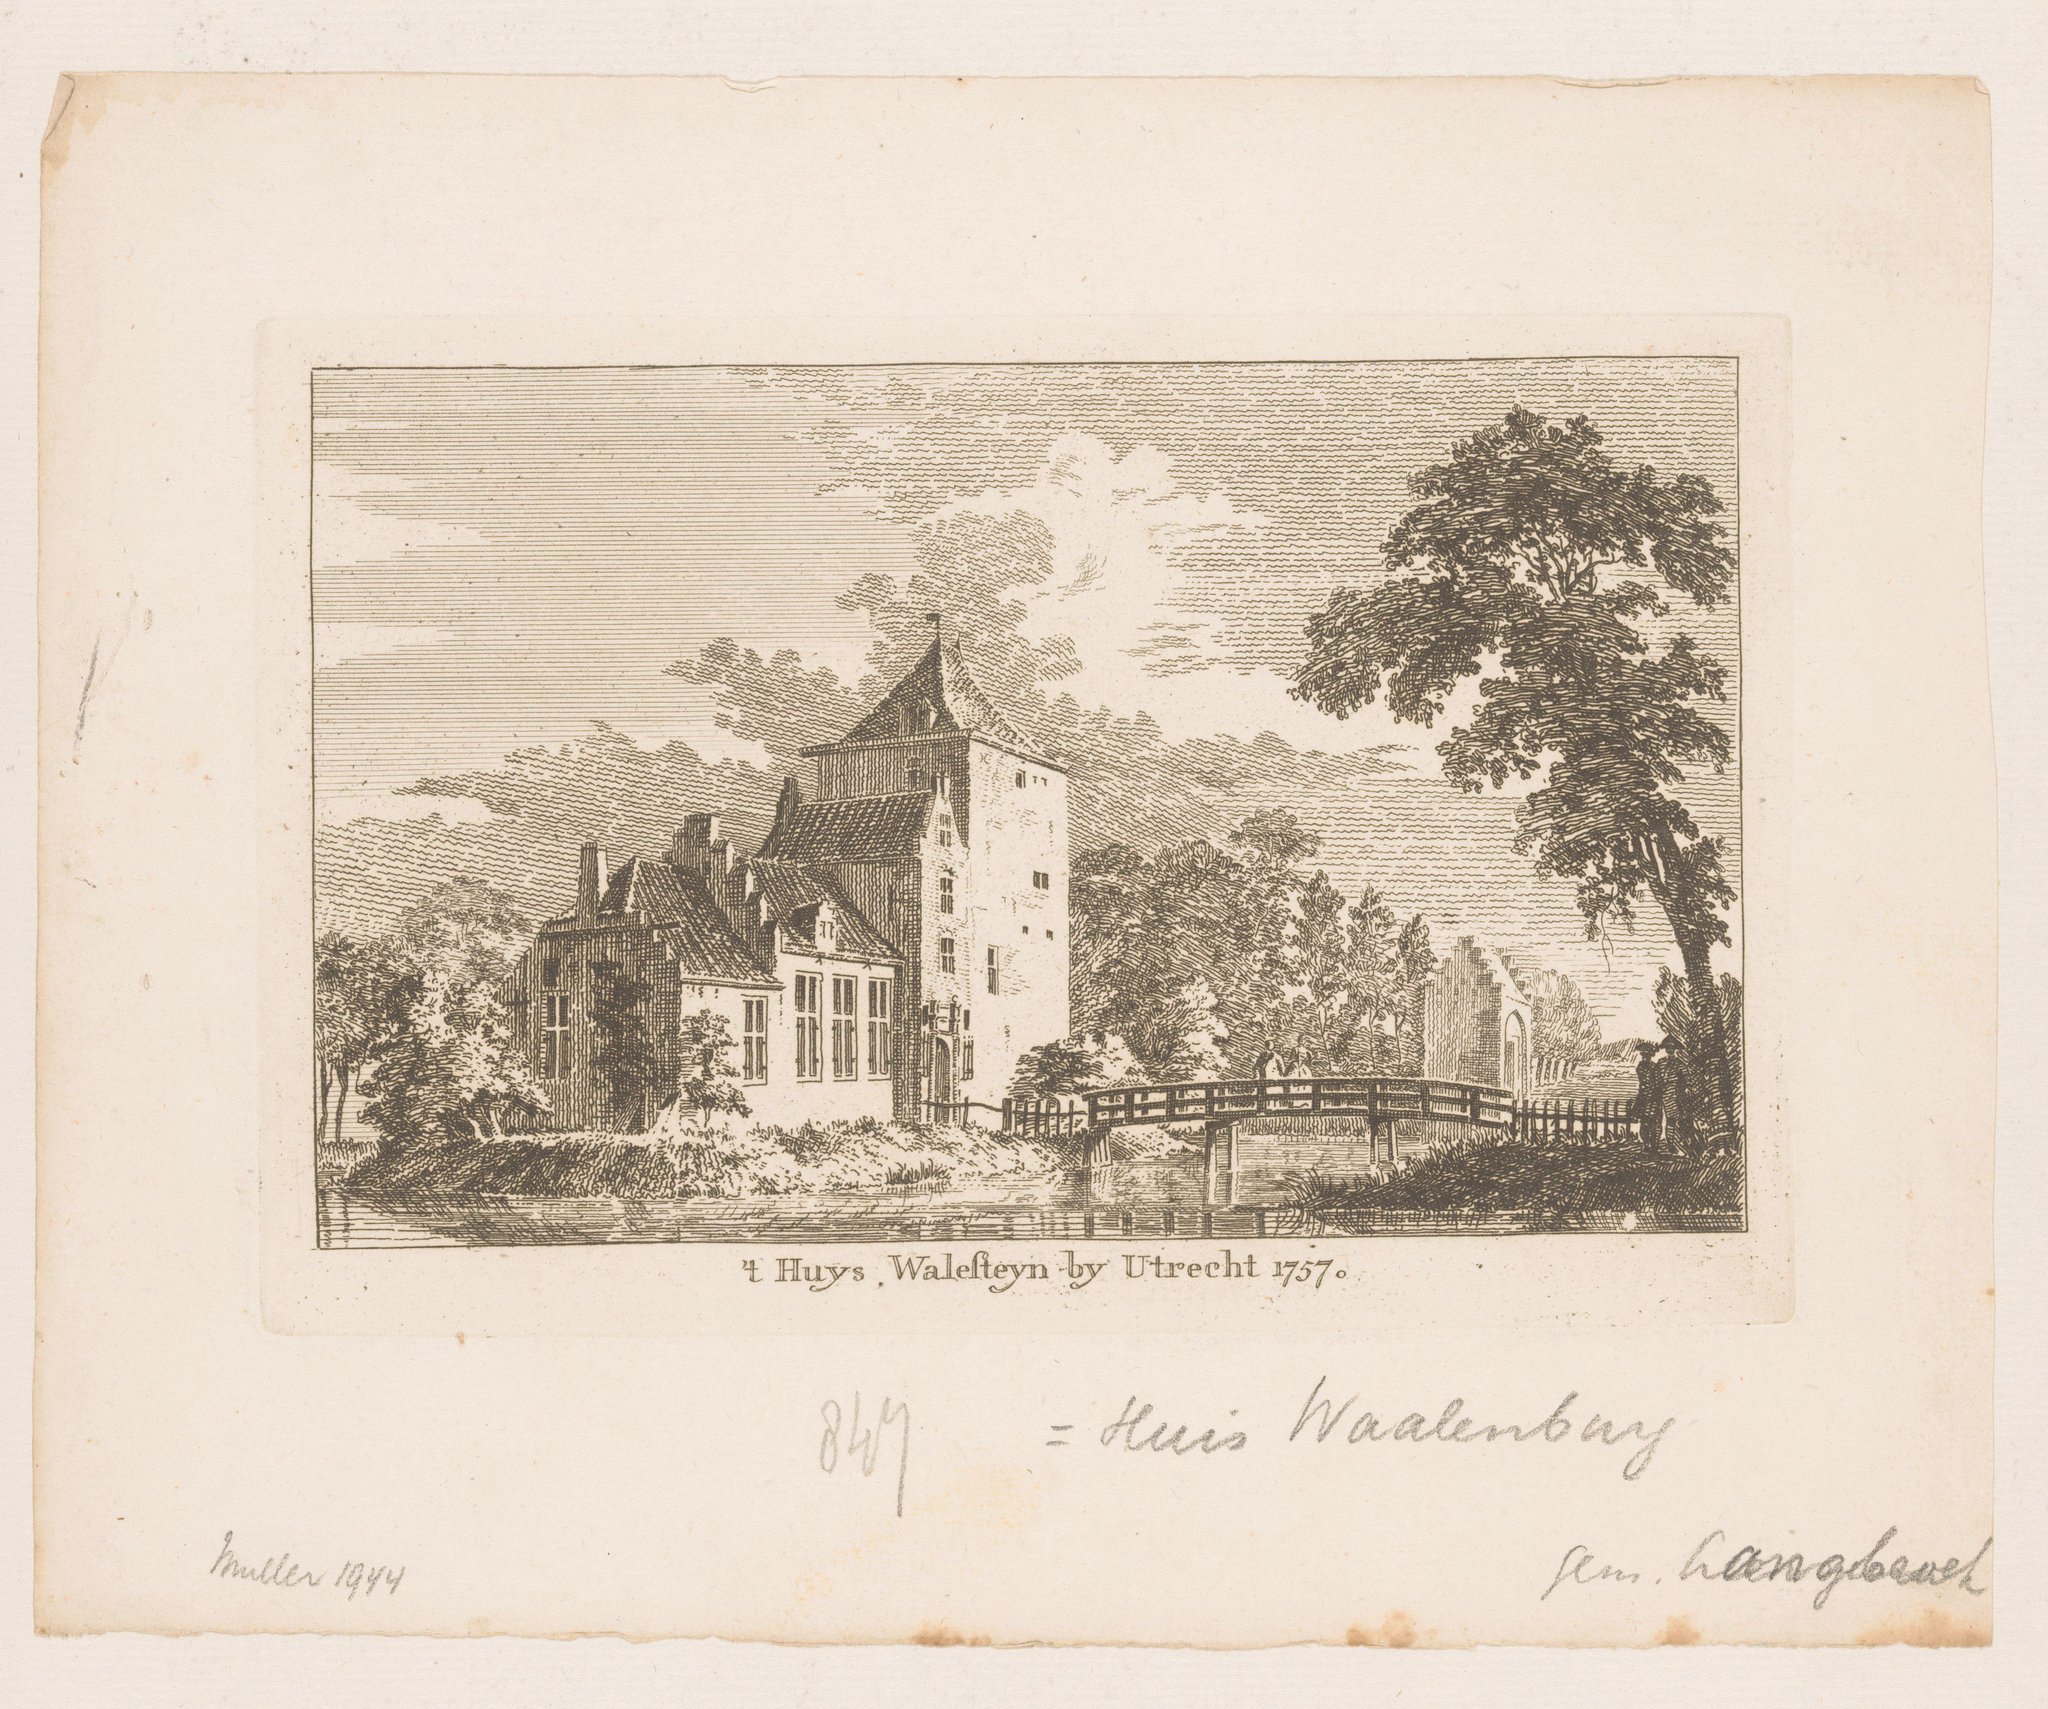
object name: print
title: 't Huys Walesteyn bij Utrecht 1757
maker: hendrik spilman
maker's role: draughtsman, painter, print maker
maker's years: 1721-1784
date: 1757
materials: paper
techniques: etching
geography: haarlem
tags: castle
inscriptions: date